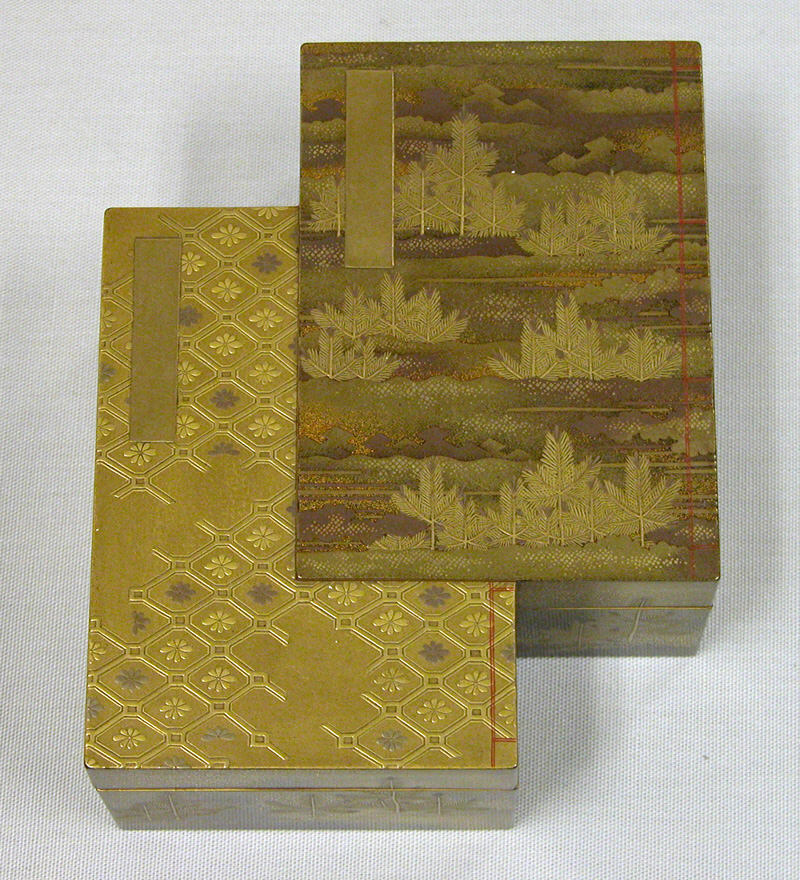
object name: cake box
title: Cake Box (?)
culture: japanese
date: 1801-1900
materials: gold, lacquer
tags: leaves